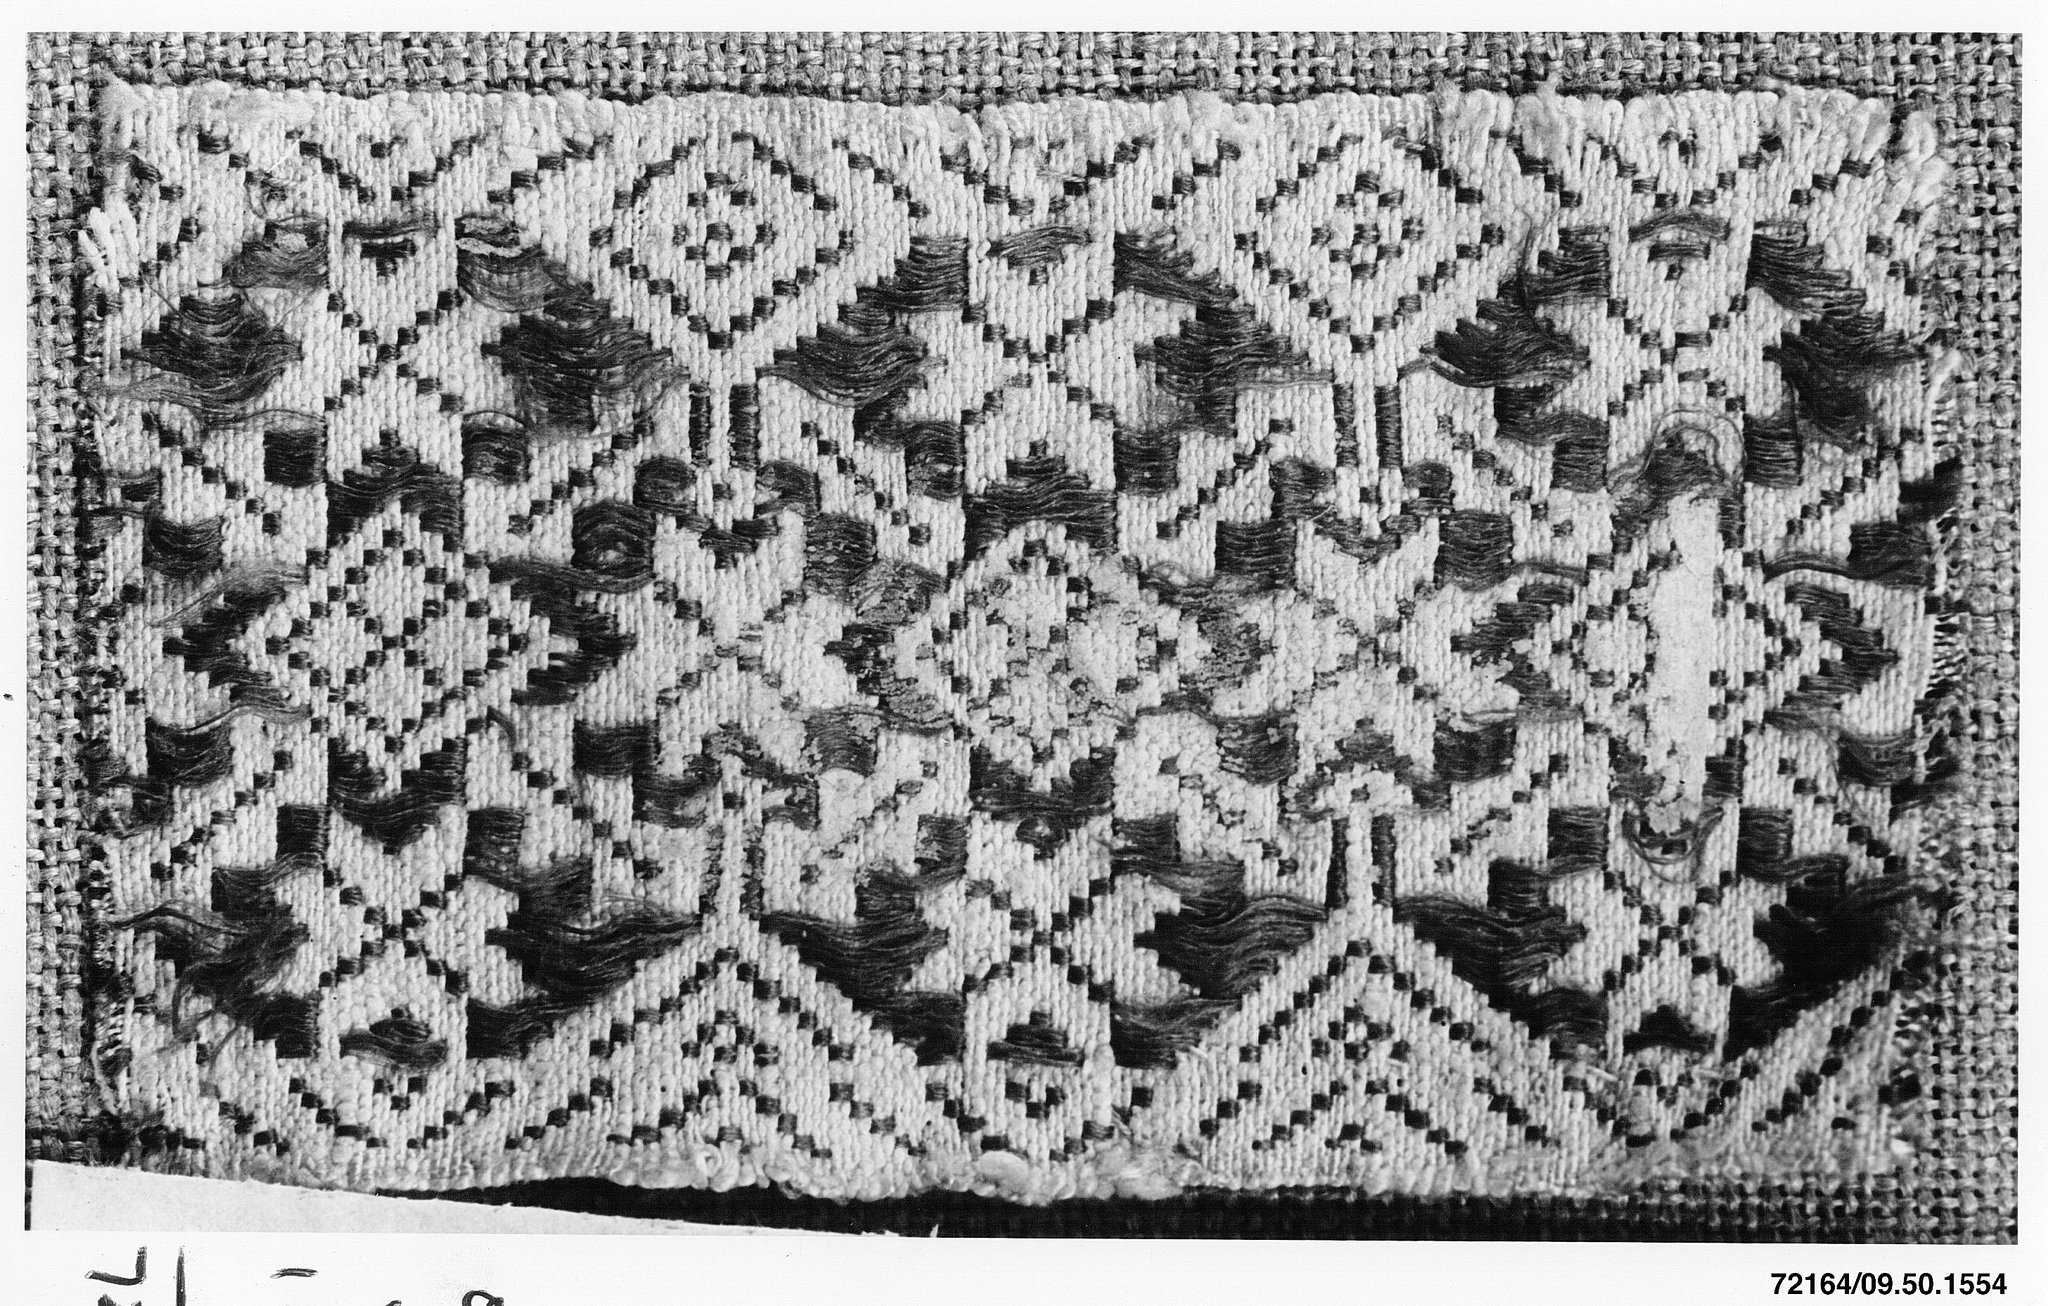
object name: band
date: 1701-1800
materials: linen, silk